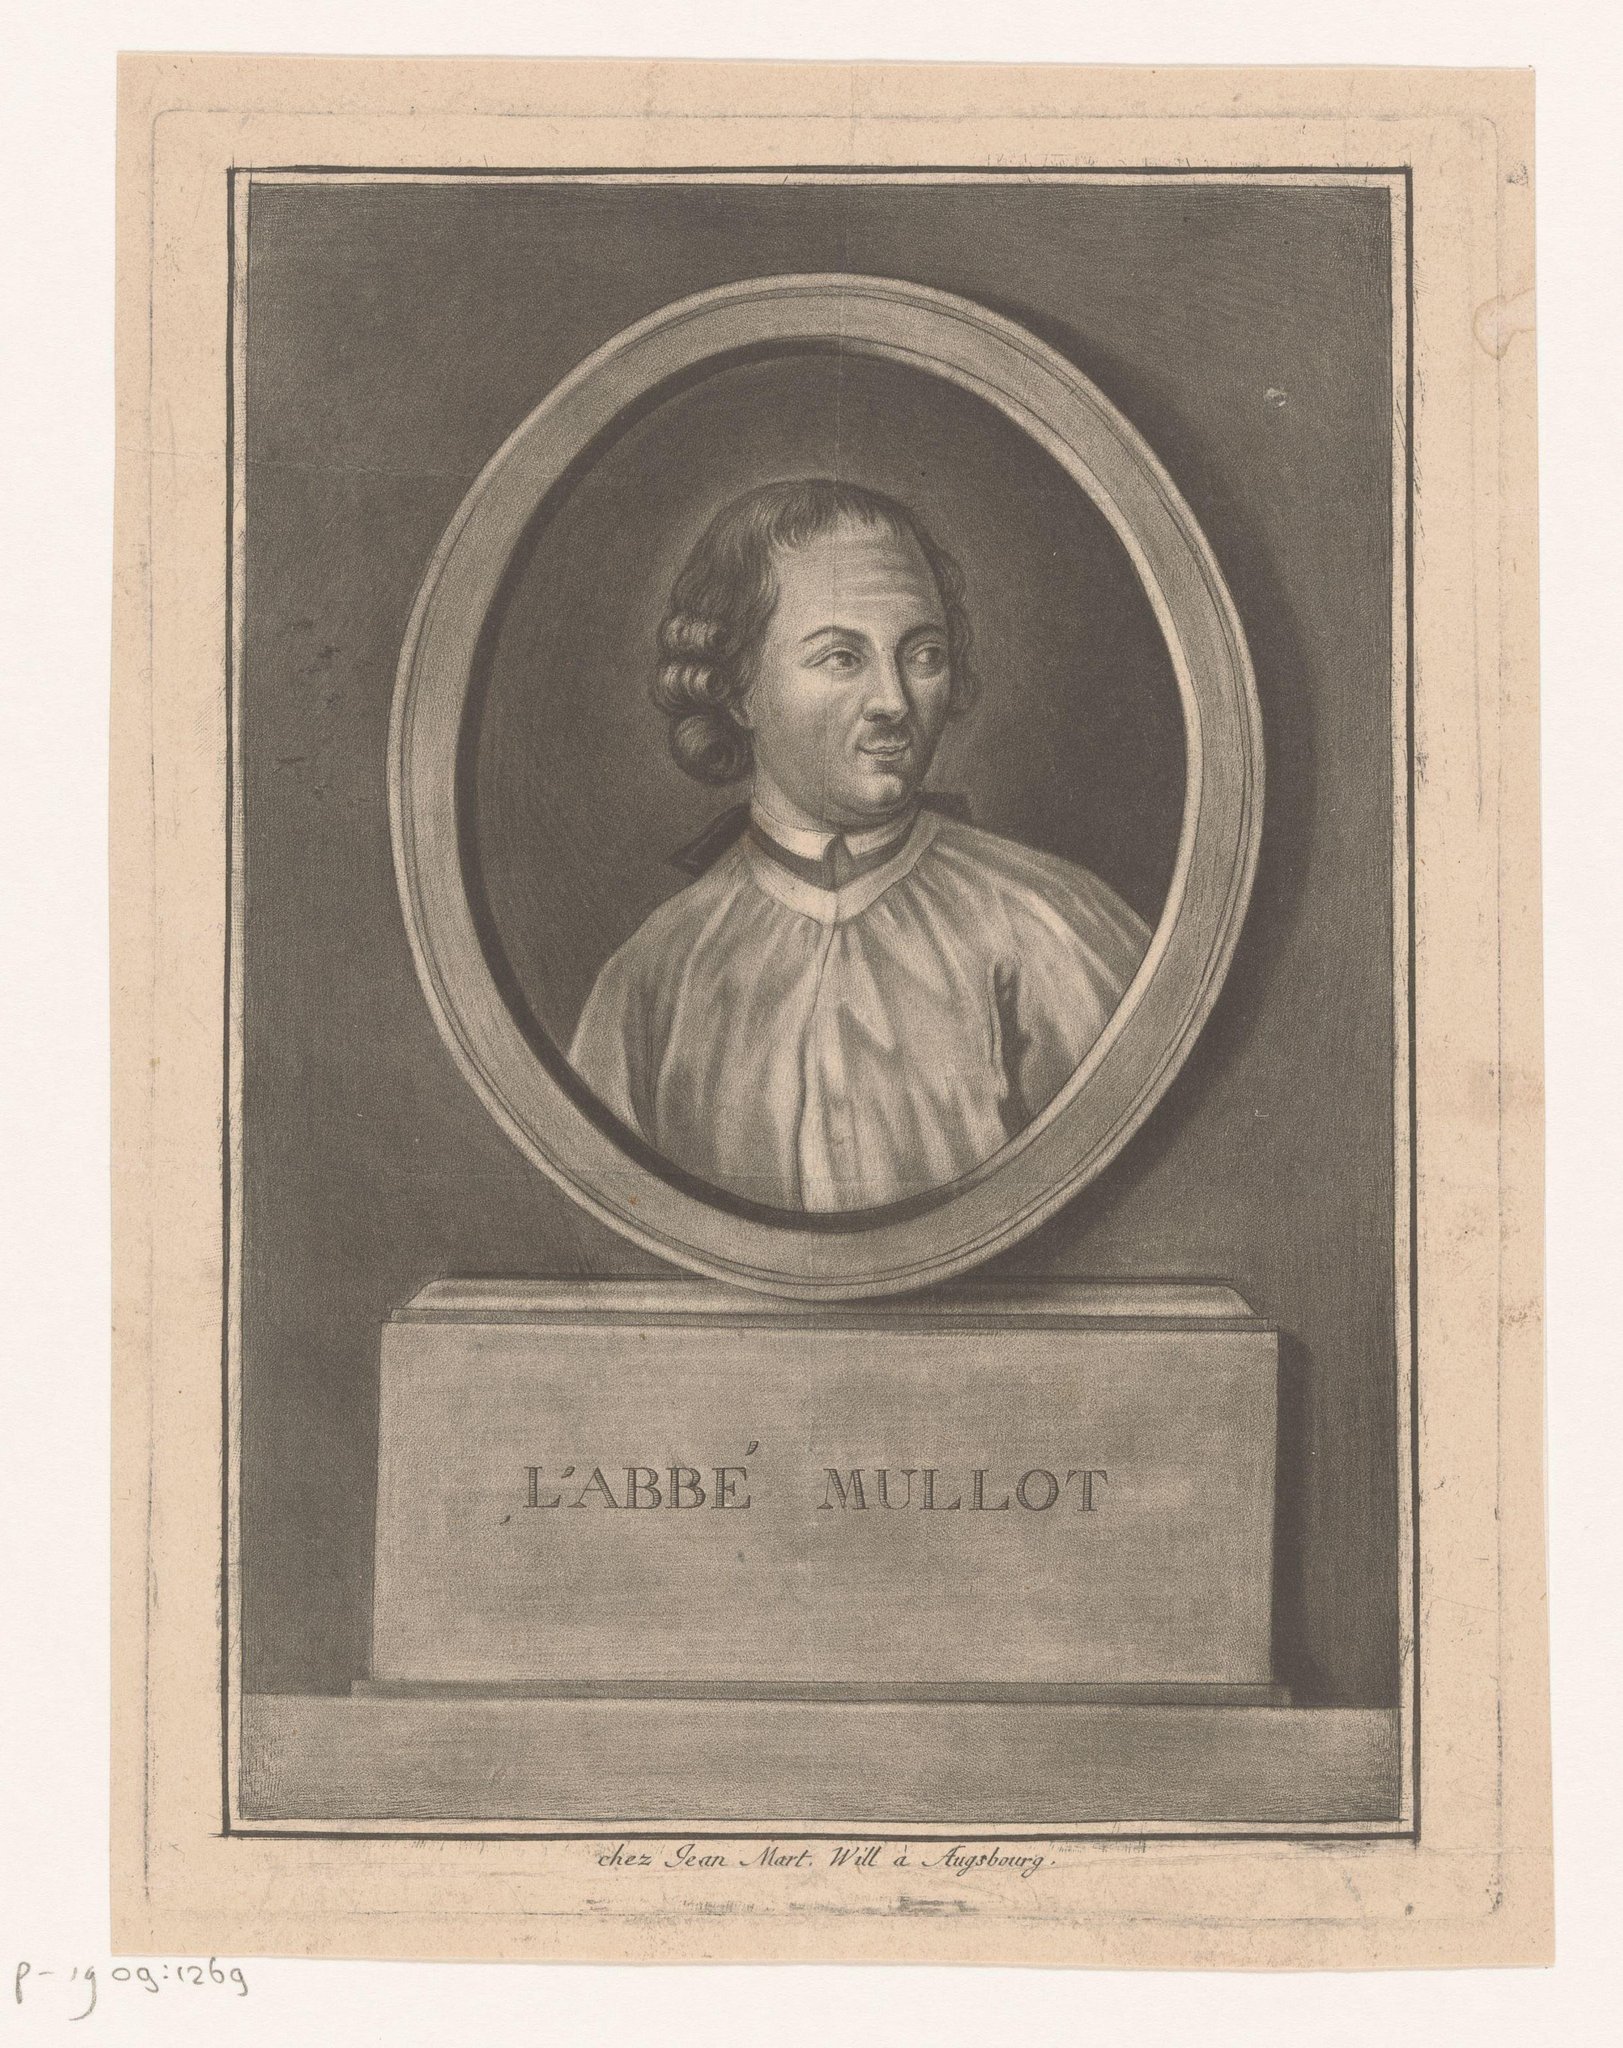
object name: print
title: Portret van François-Valentin Mulot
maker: johann martin will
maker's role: print maker, publisher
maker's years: 1727-1806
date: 1759-1806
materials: paper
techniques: mezzotint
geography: augsburg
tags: paris, historical persons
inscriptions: collector's mark: Lugt 2228